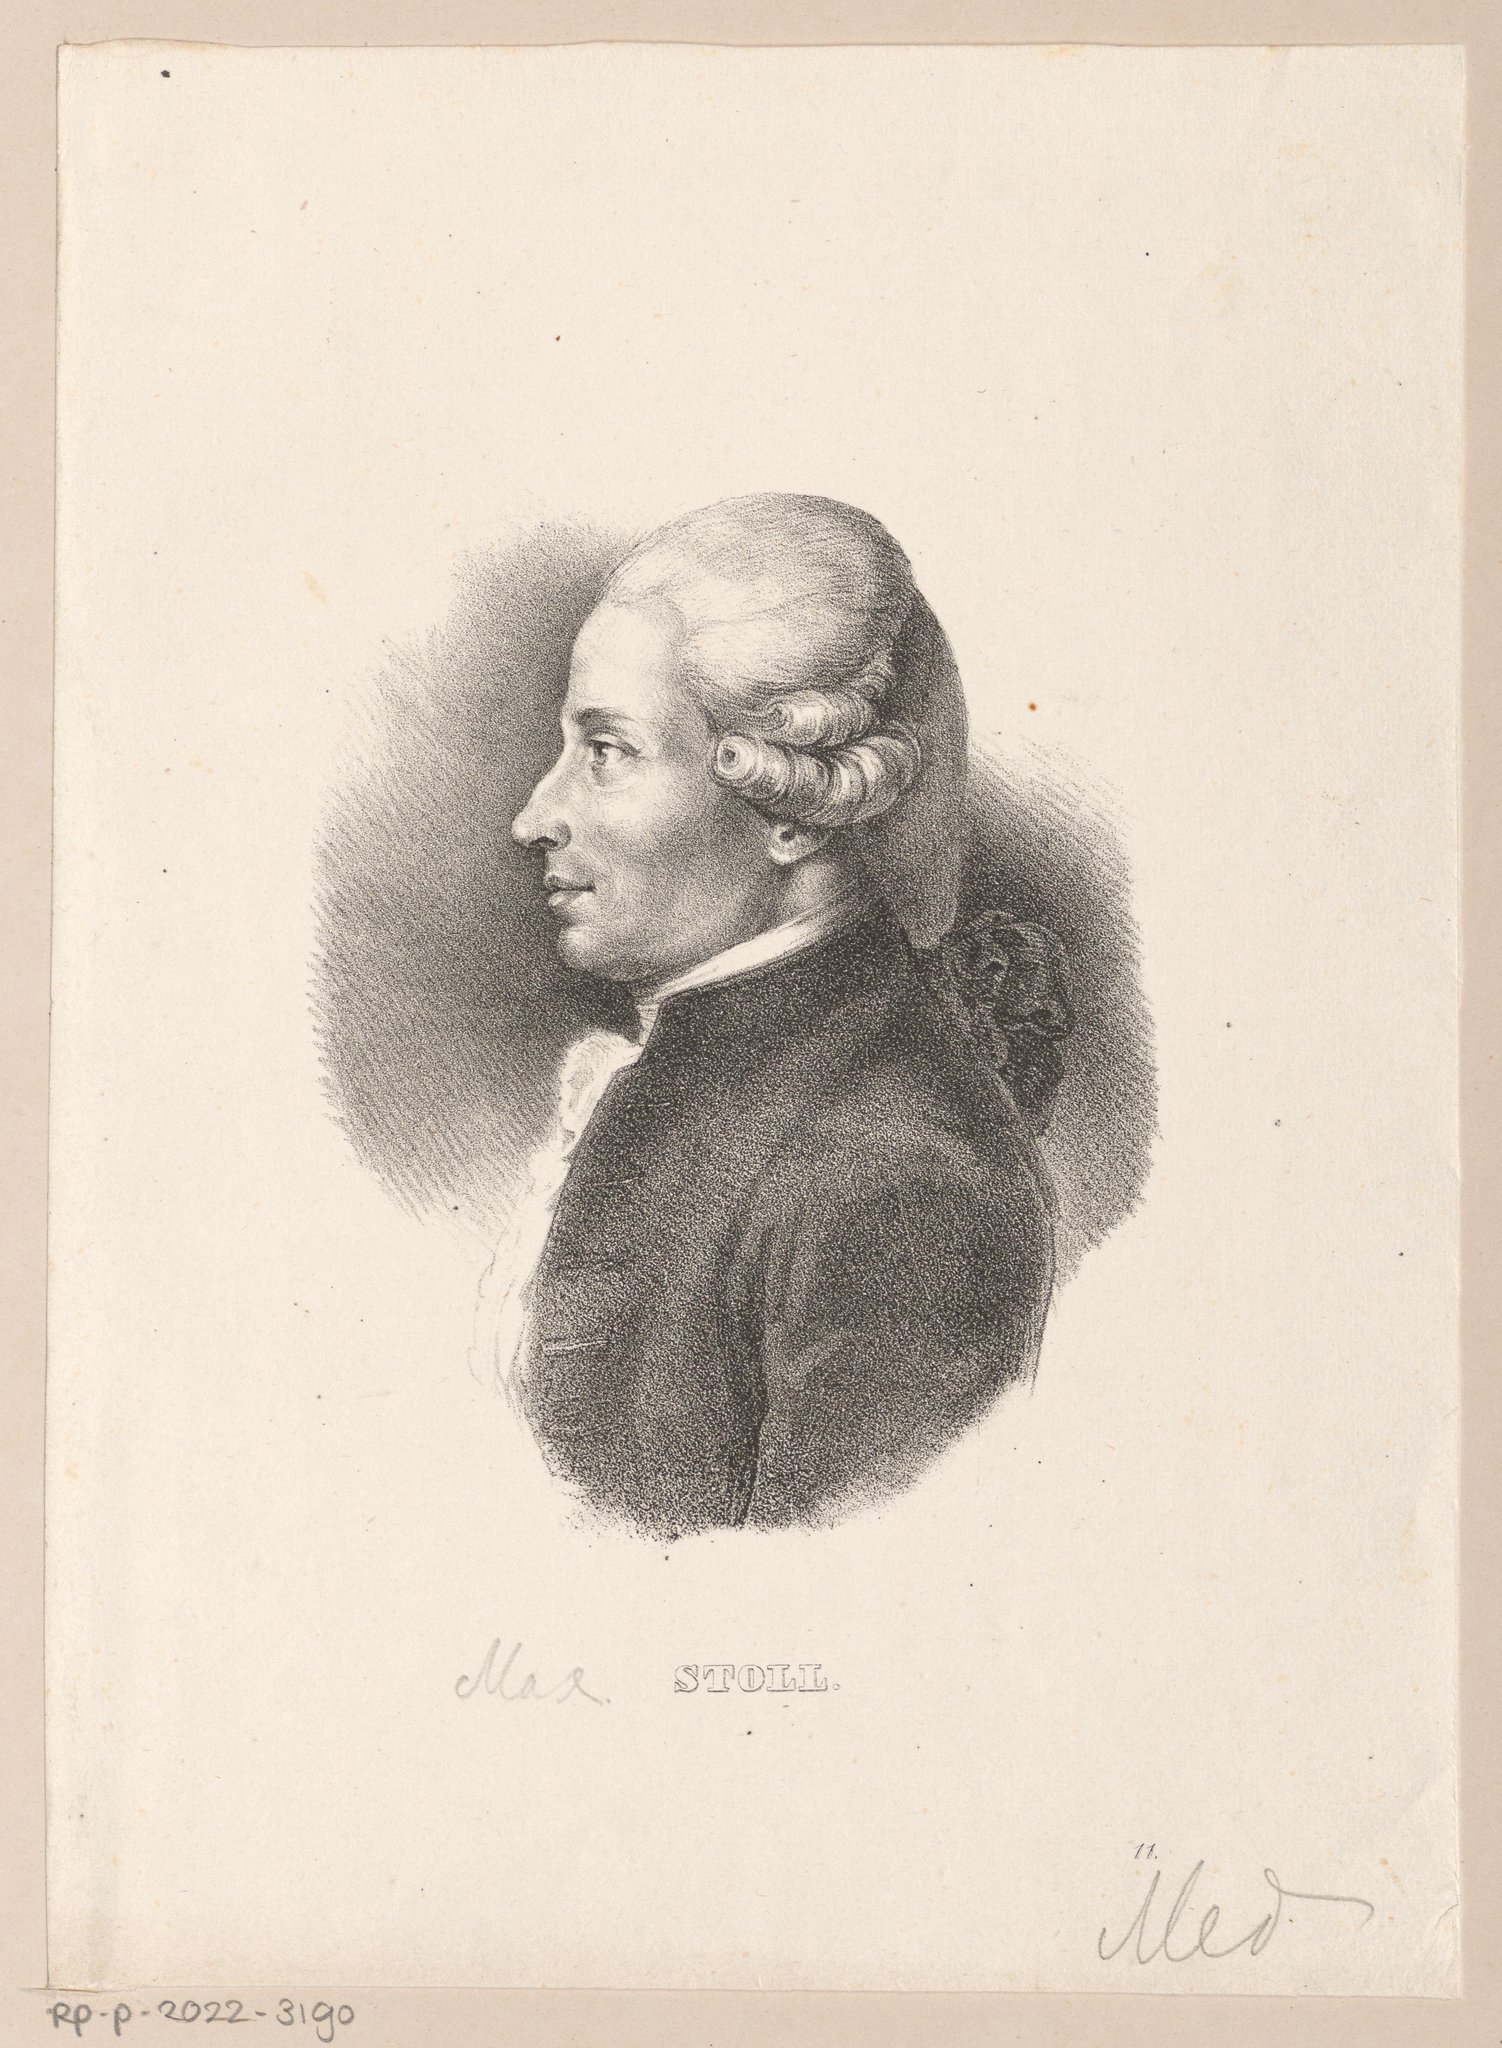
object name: print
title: Portret van Maximilian Stoll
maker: Anonymous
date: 1798-1850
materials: paper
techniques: lithograph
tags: historical persons, physician, doctor